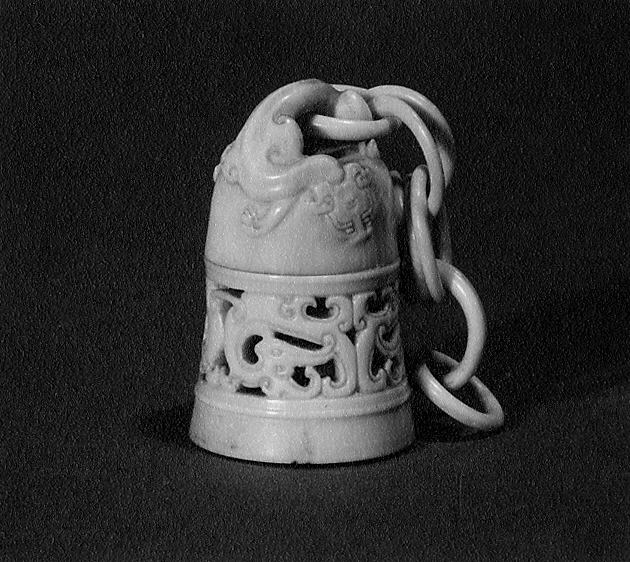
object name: seal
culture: chinese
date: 1701-1800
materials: ivory